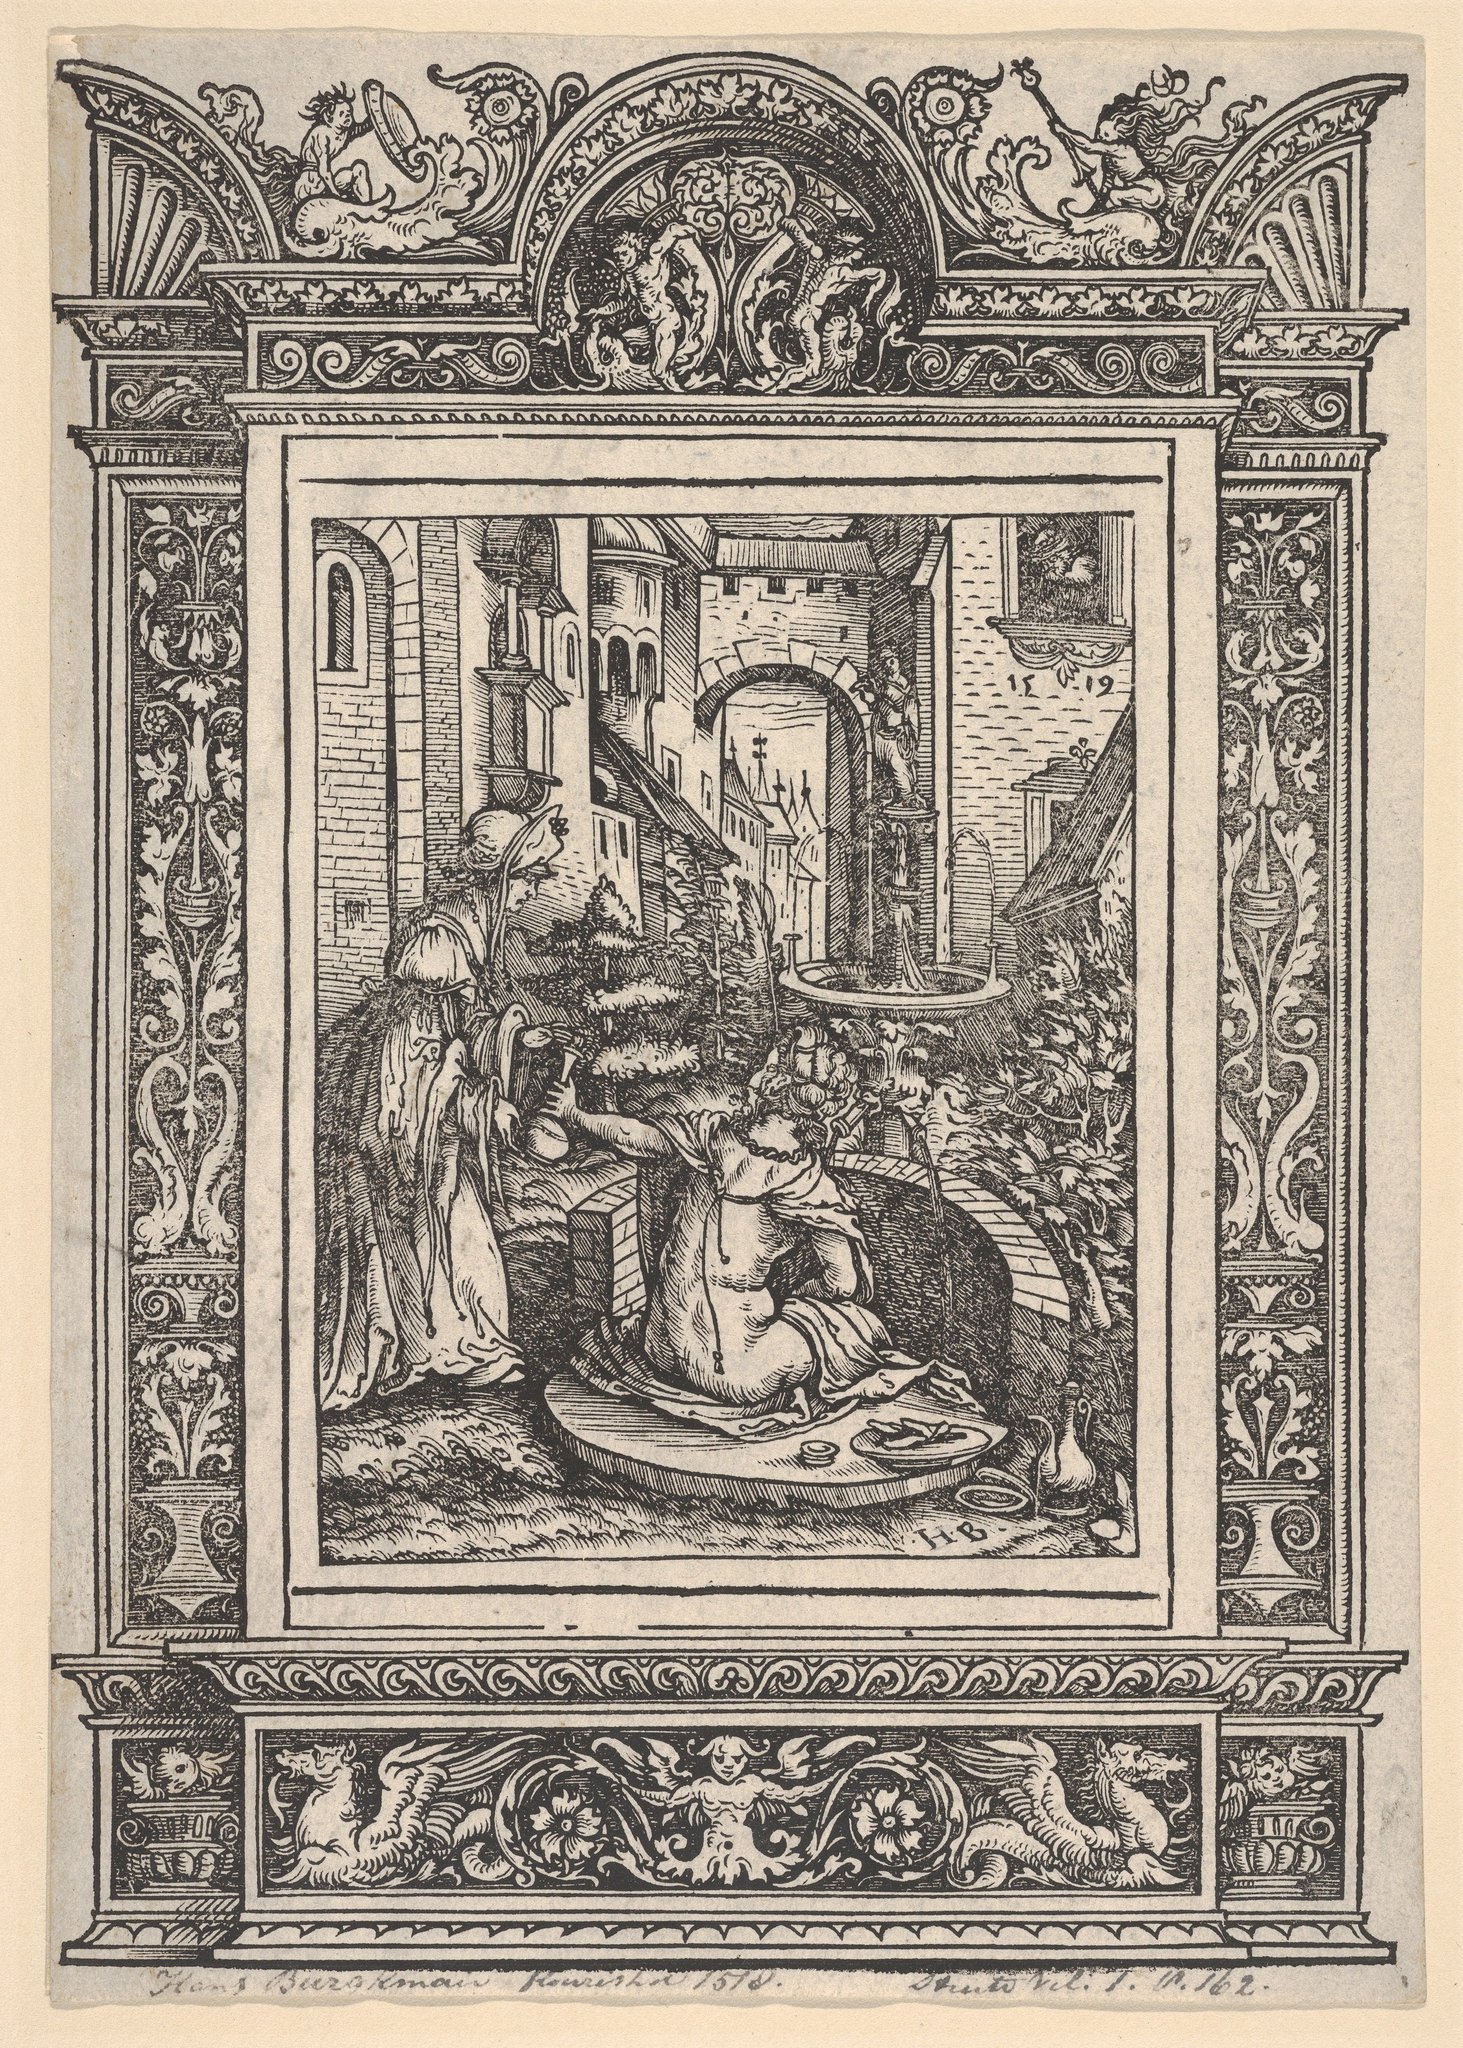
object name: print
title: Bathsheba Bathing, from "Women's Wile" (Weiberlisten)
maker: hans burgkmair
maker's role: artist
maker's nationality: german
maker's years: 1473-1531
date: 1522-1536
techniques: woodcut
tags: women,bathsheba,bathing